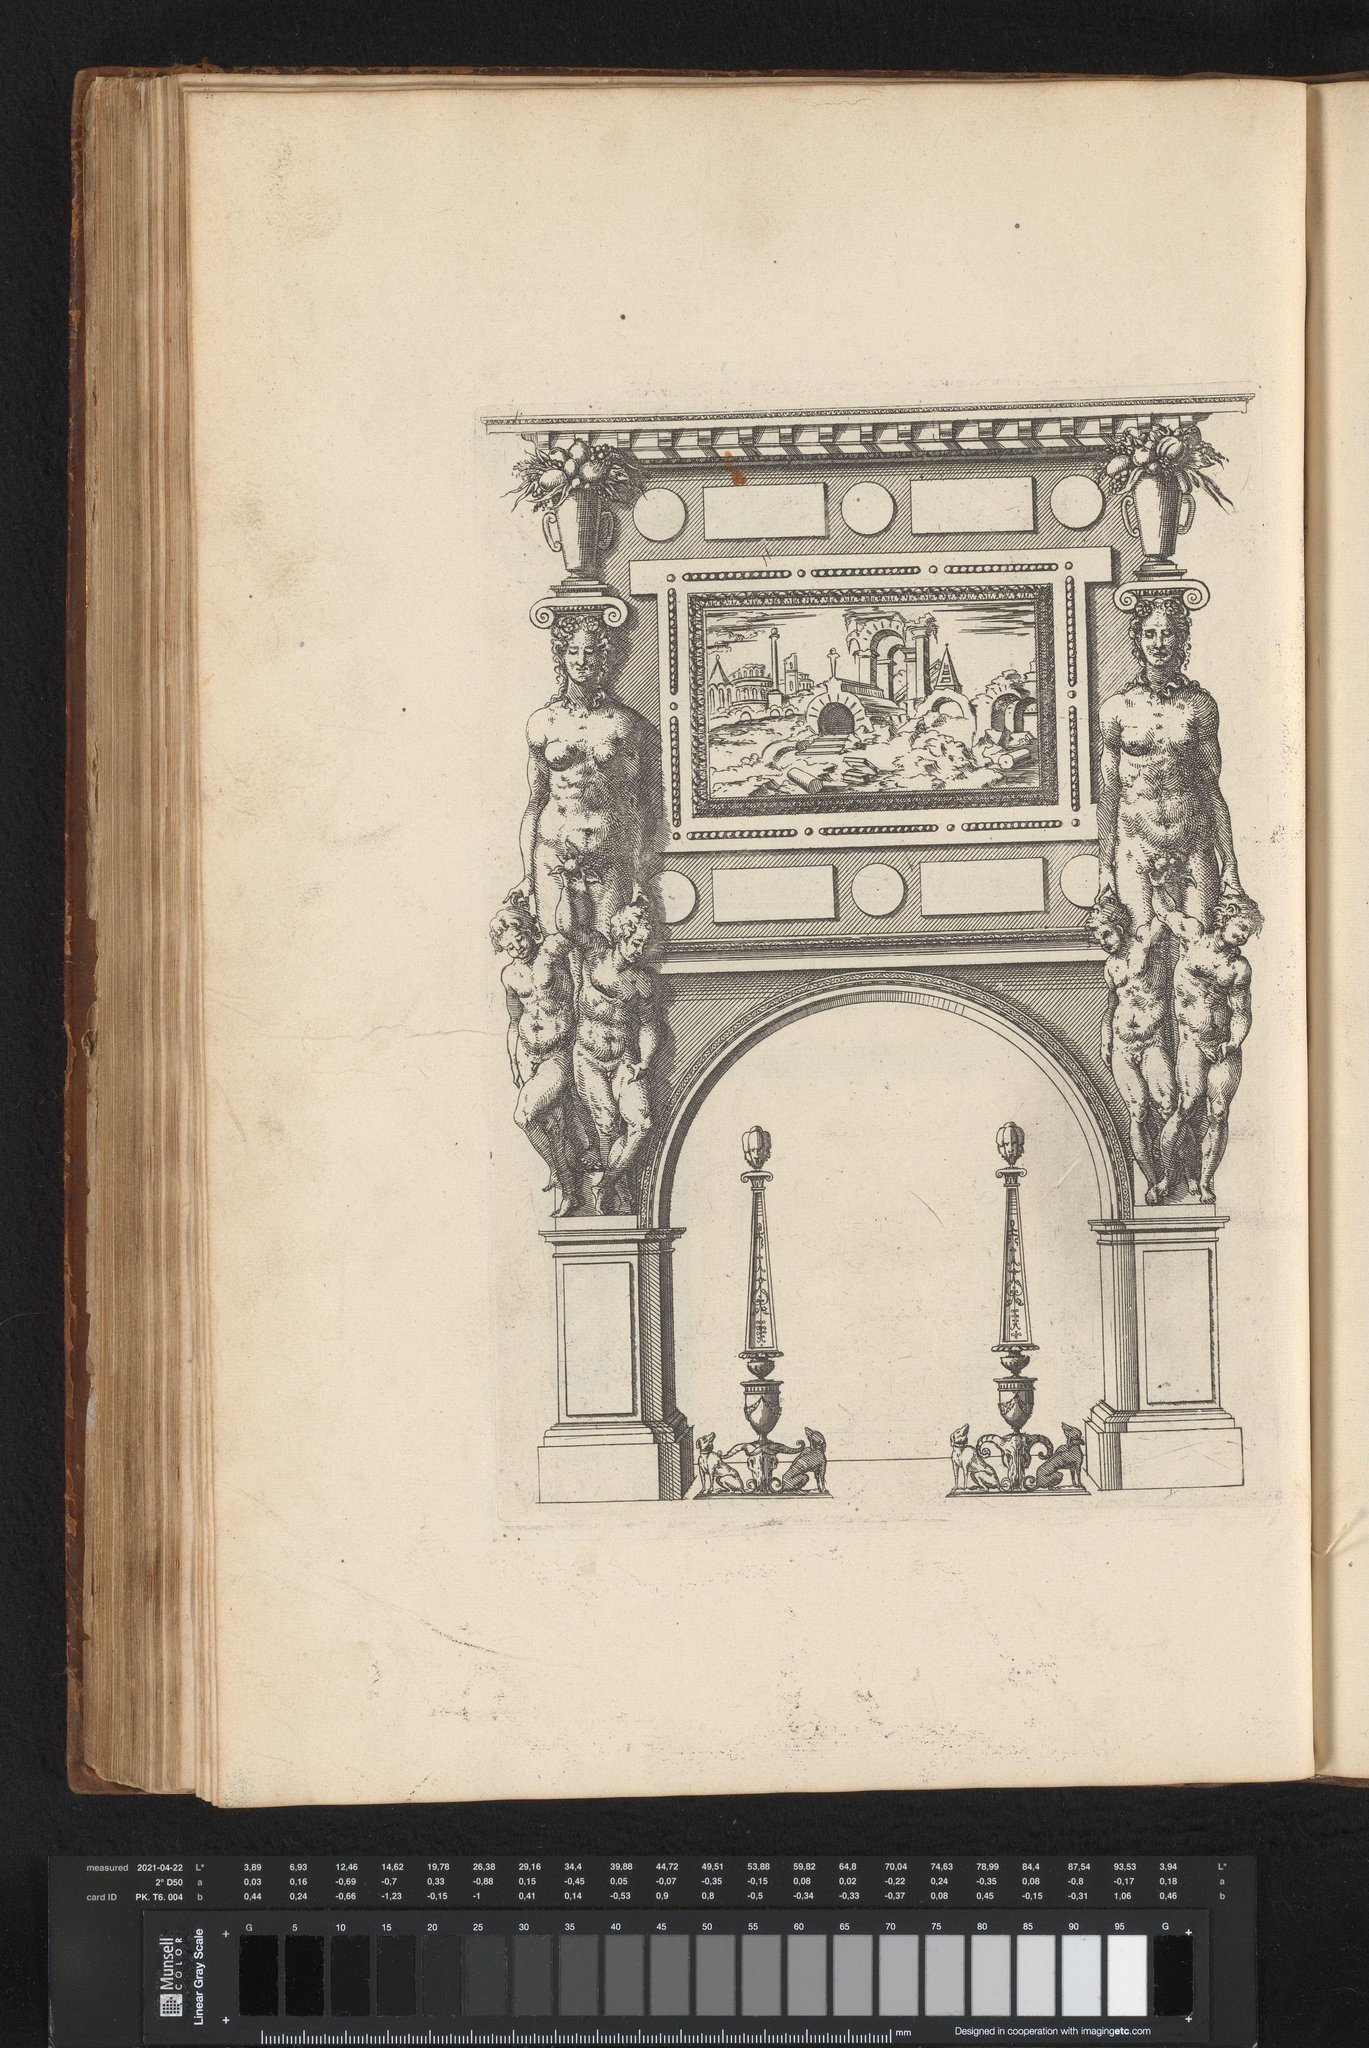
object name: ornament print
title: Schoorsteenmantel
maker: jacques androuet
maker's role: draughtsman, print maker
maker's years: 1515-1584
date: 1561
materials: paper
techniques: etching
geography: paris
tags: caryatids ~ architecture, landscape with ruins, piece of sculpture, reproduction of a piece of sculpture, architectural design or model, chimney-piece, mantelpiece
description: Schoorsteenmantel met kariatiden en op de schouw een voorstelling van antieke ruïnes. Onderdeel van 'Seconde livre d'architectvre' (1561): 64 etsen met geornamenteerde architectuuronderdelen.